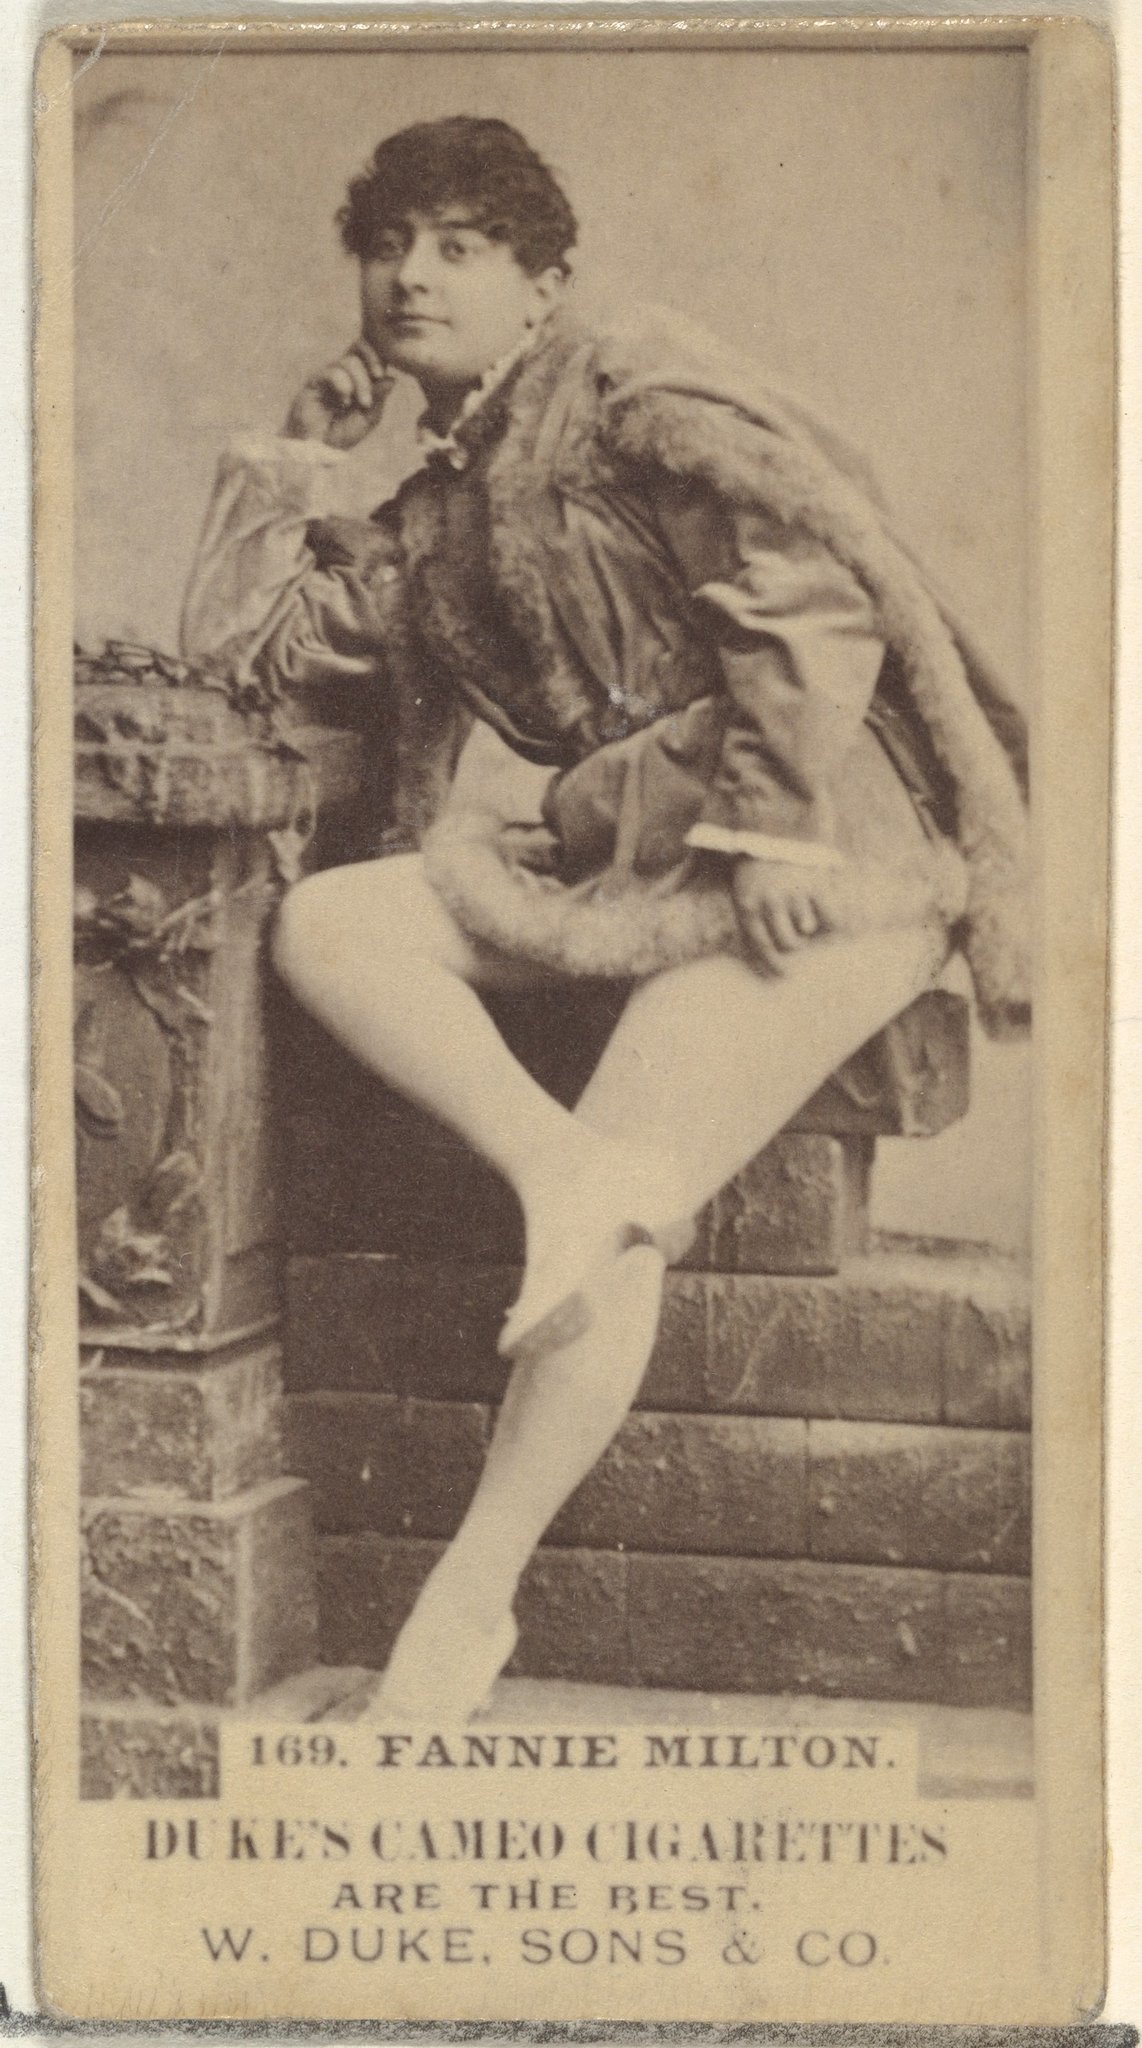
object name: photograph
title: Card Number 169, Fannie Milton, from the Actors and Actresses series (N145-5) issued by Duke Sons & Co. to promote Cameo Cigarettes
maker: w. duke, sons & co.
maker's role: publisher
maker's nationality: american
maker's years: 1870-1920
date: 1880-1889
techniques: albumen silver print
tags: portraits,women,actresses